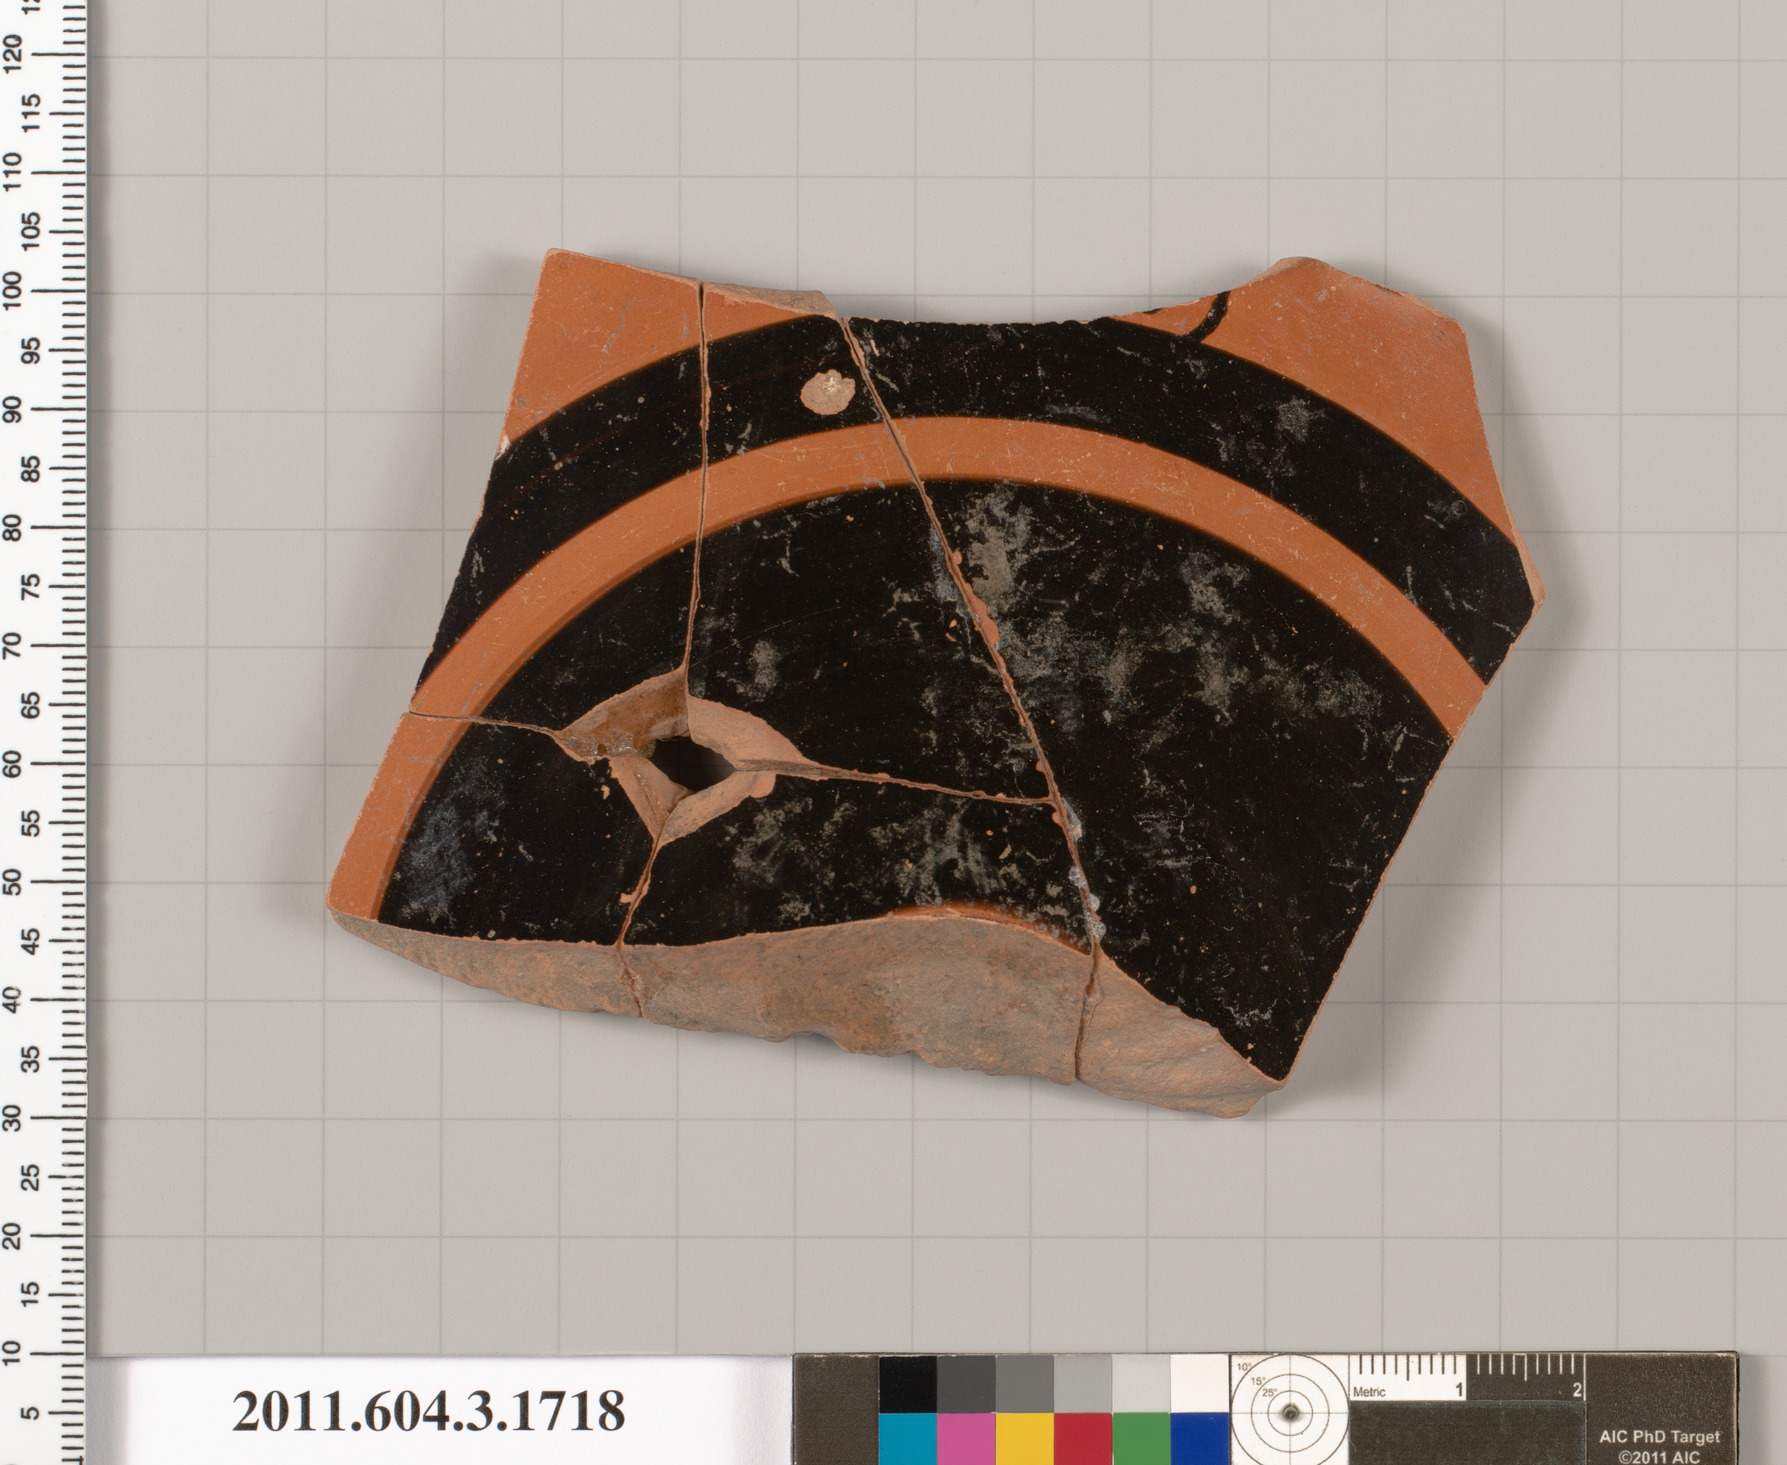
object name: kylix fragment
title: Terracotta fragment of a kylix: Lip cup (drinking cup)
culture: greek, attic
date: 550-526 BCE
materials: terracotta